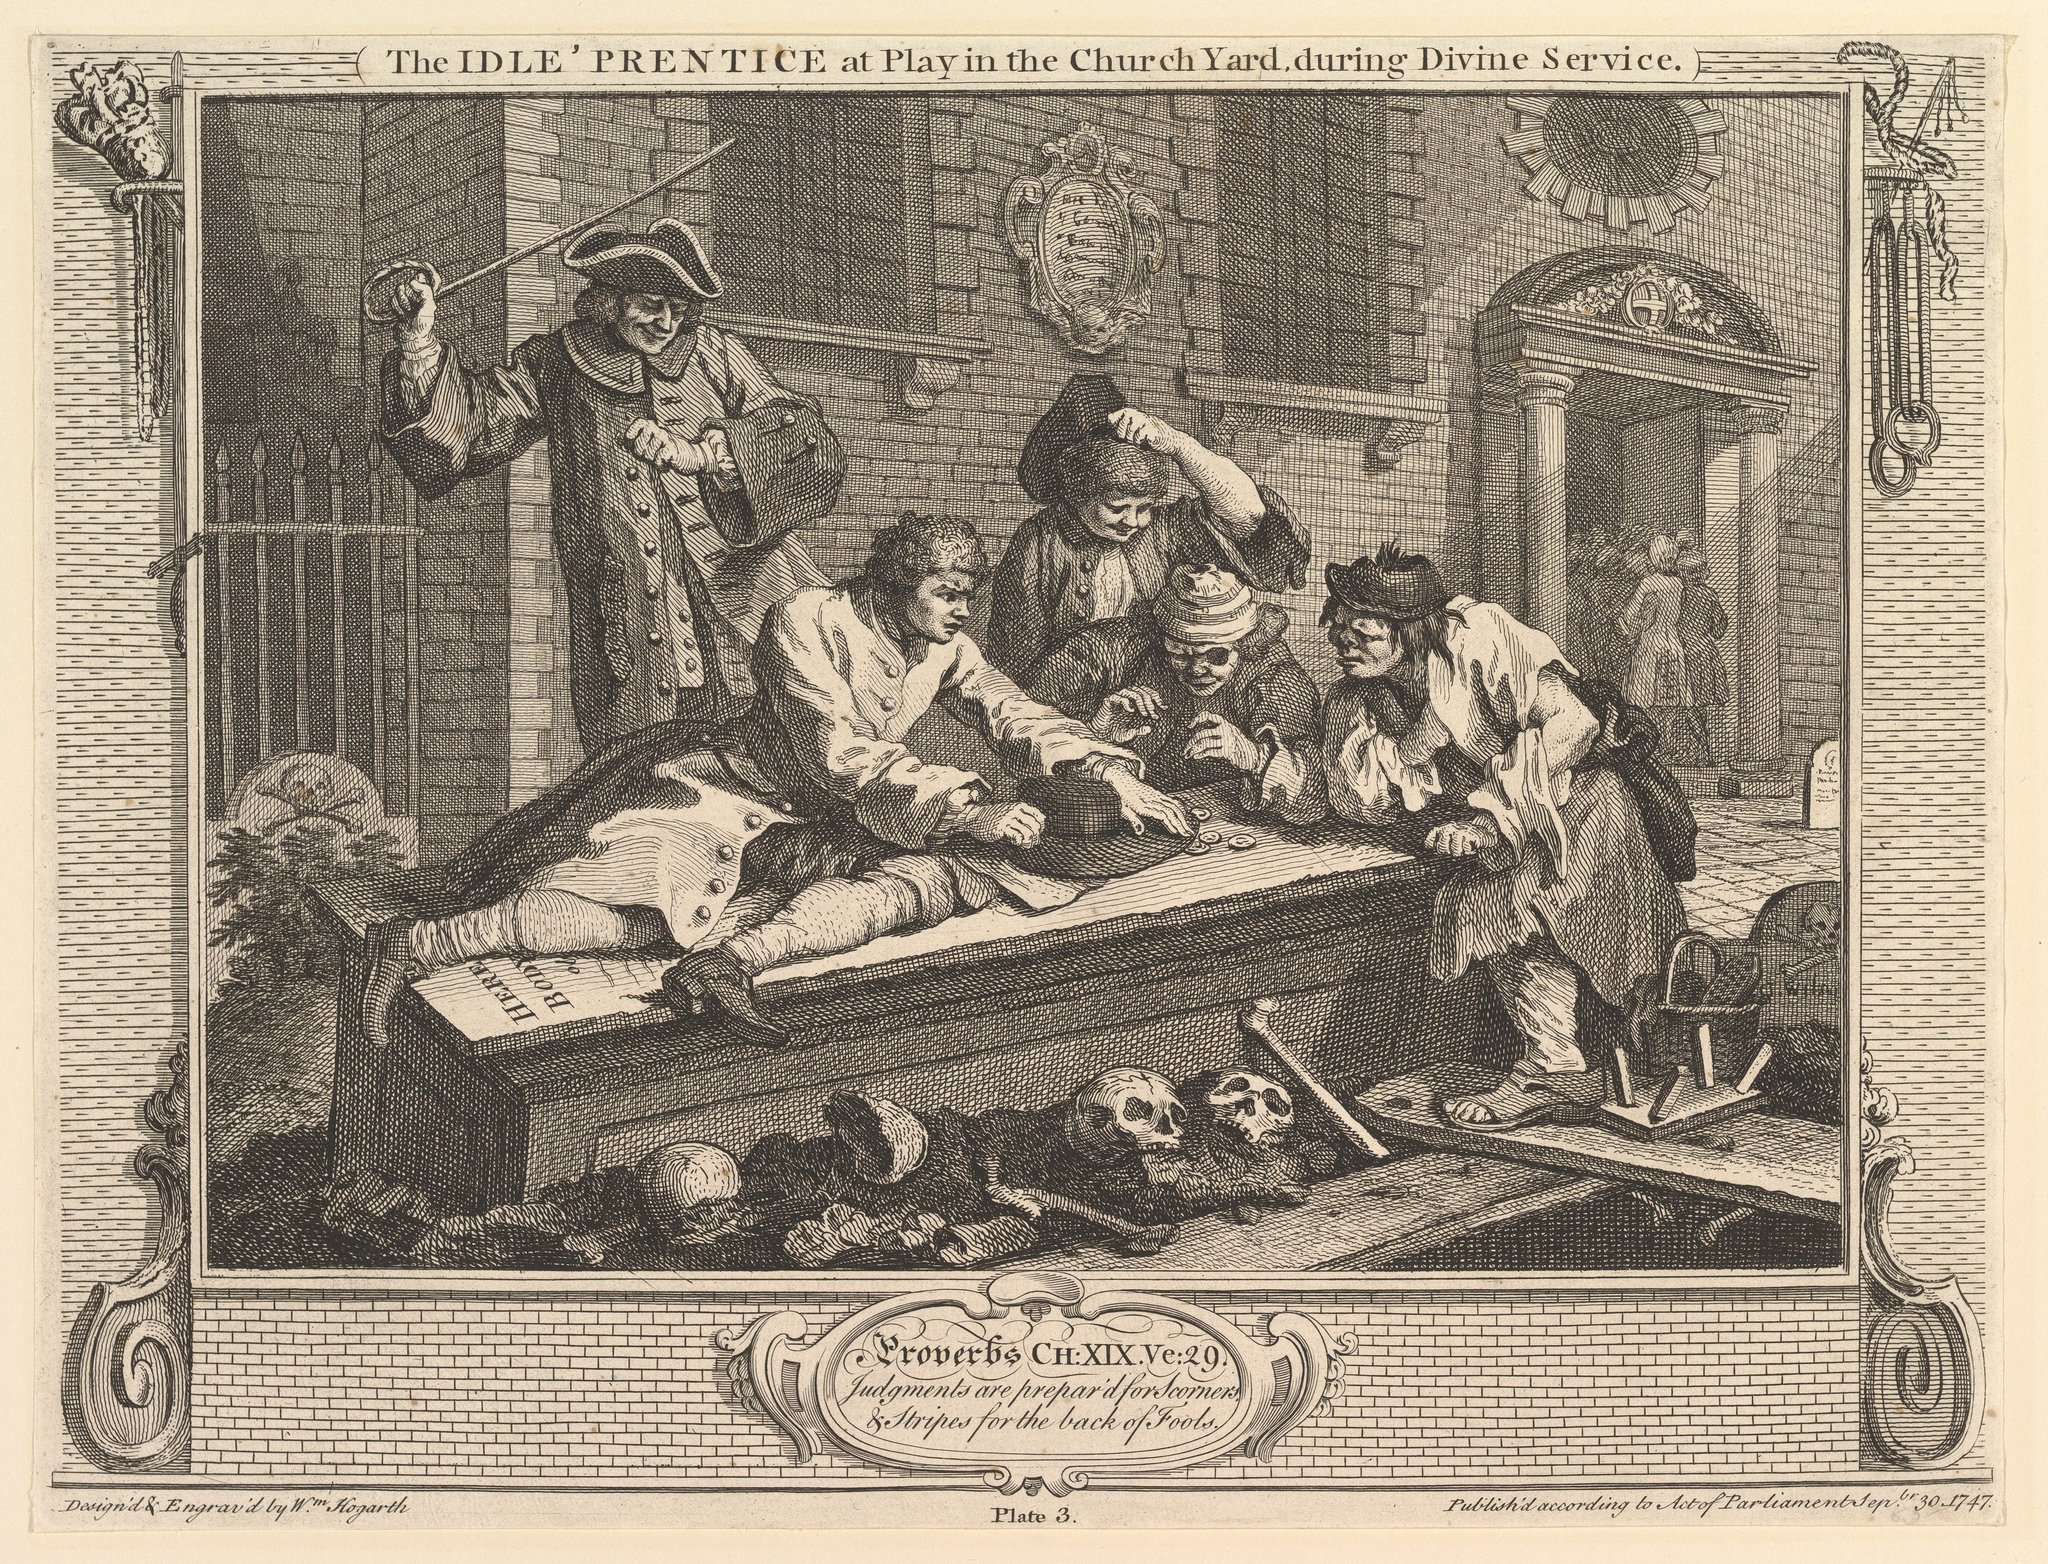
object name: print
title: The Idle 'Prentice at Play in the Churchyard: Industry and Idleness, plate 3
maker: william hogarth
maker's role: artist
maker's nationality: british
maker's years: 1697-1764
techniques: engraving, etching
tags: skulls,men